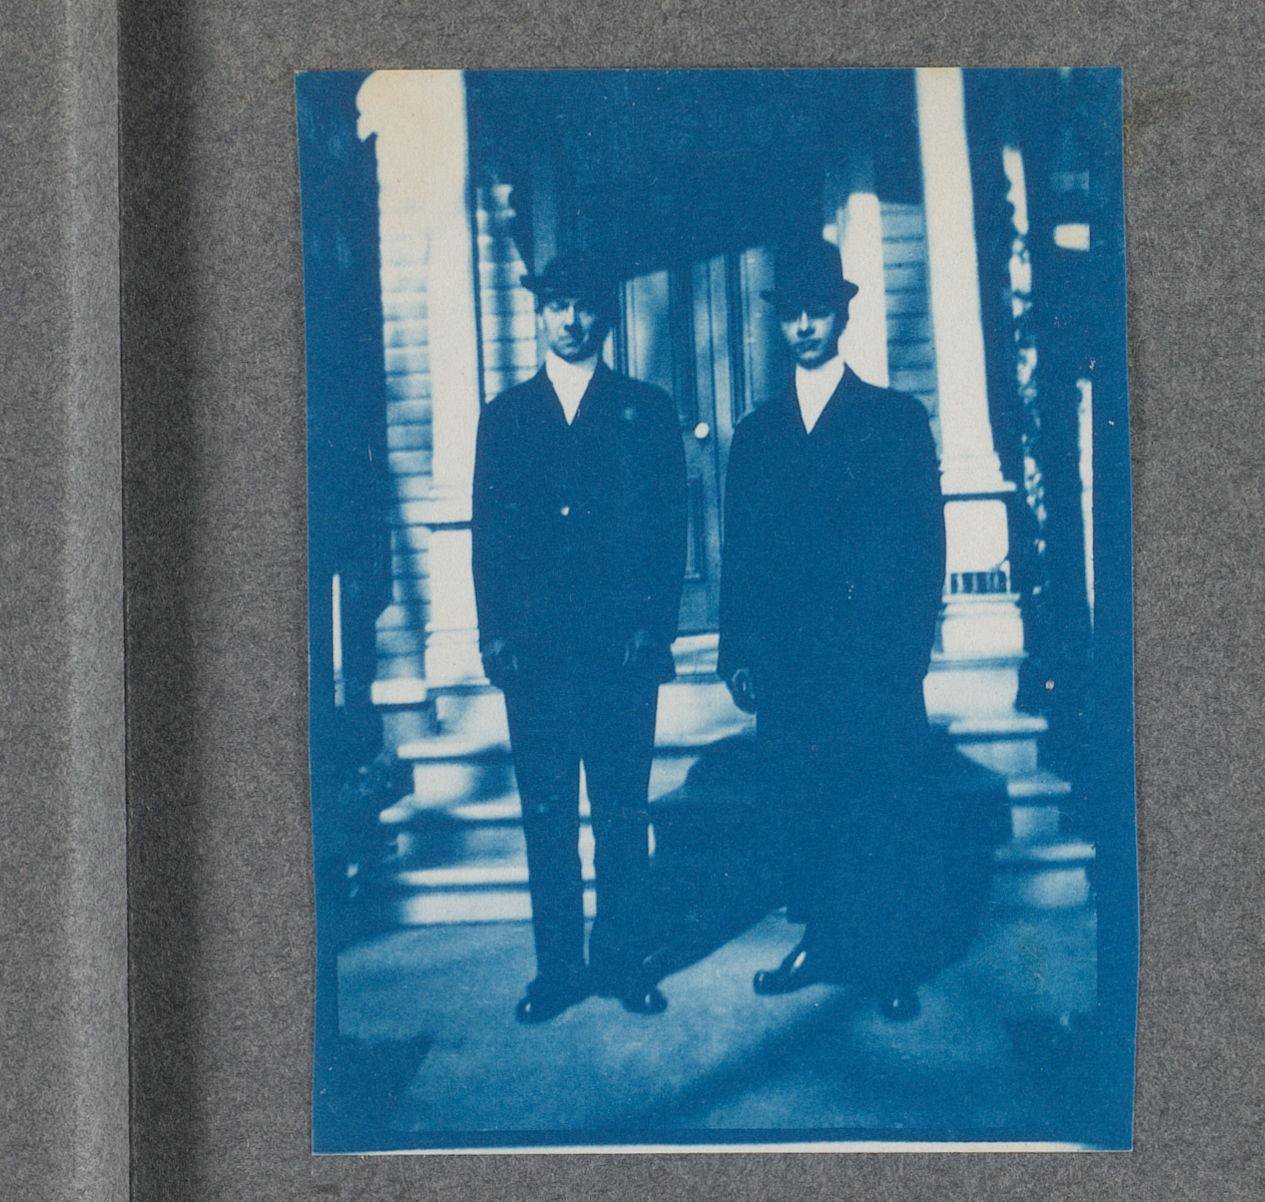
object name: photograph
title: Twee studenten, mogelijk op de campus van Denison University in Ohio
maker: Anonymous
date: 1910-1920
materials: paper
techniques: cyanotype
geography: granville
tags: student